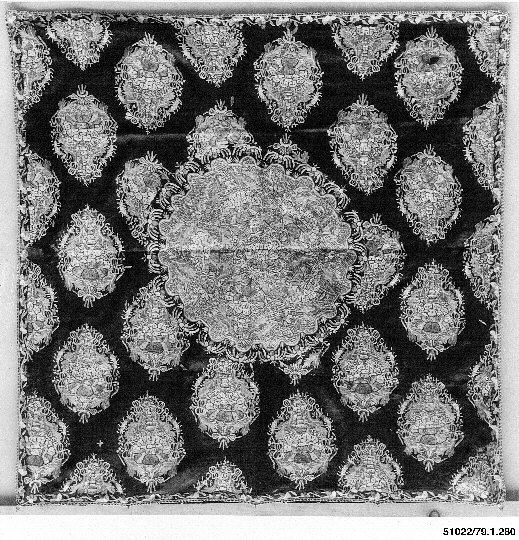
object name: cover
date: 1701-1833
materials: metal thread, silk, wool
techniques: embroidery, weave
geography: turkey